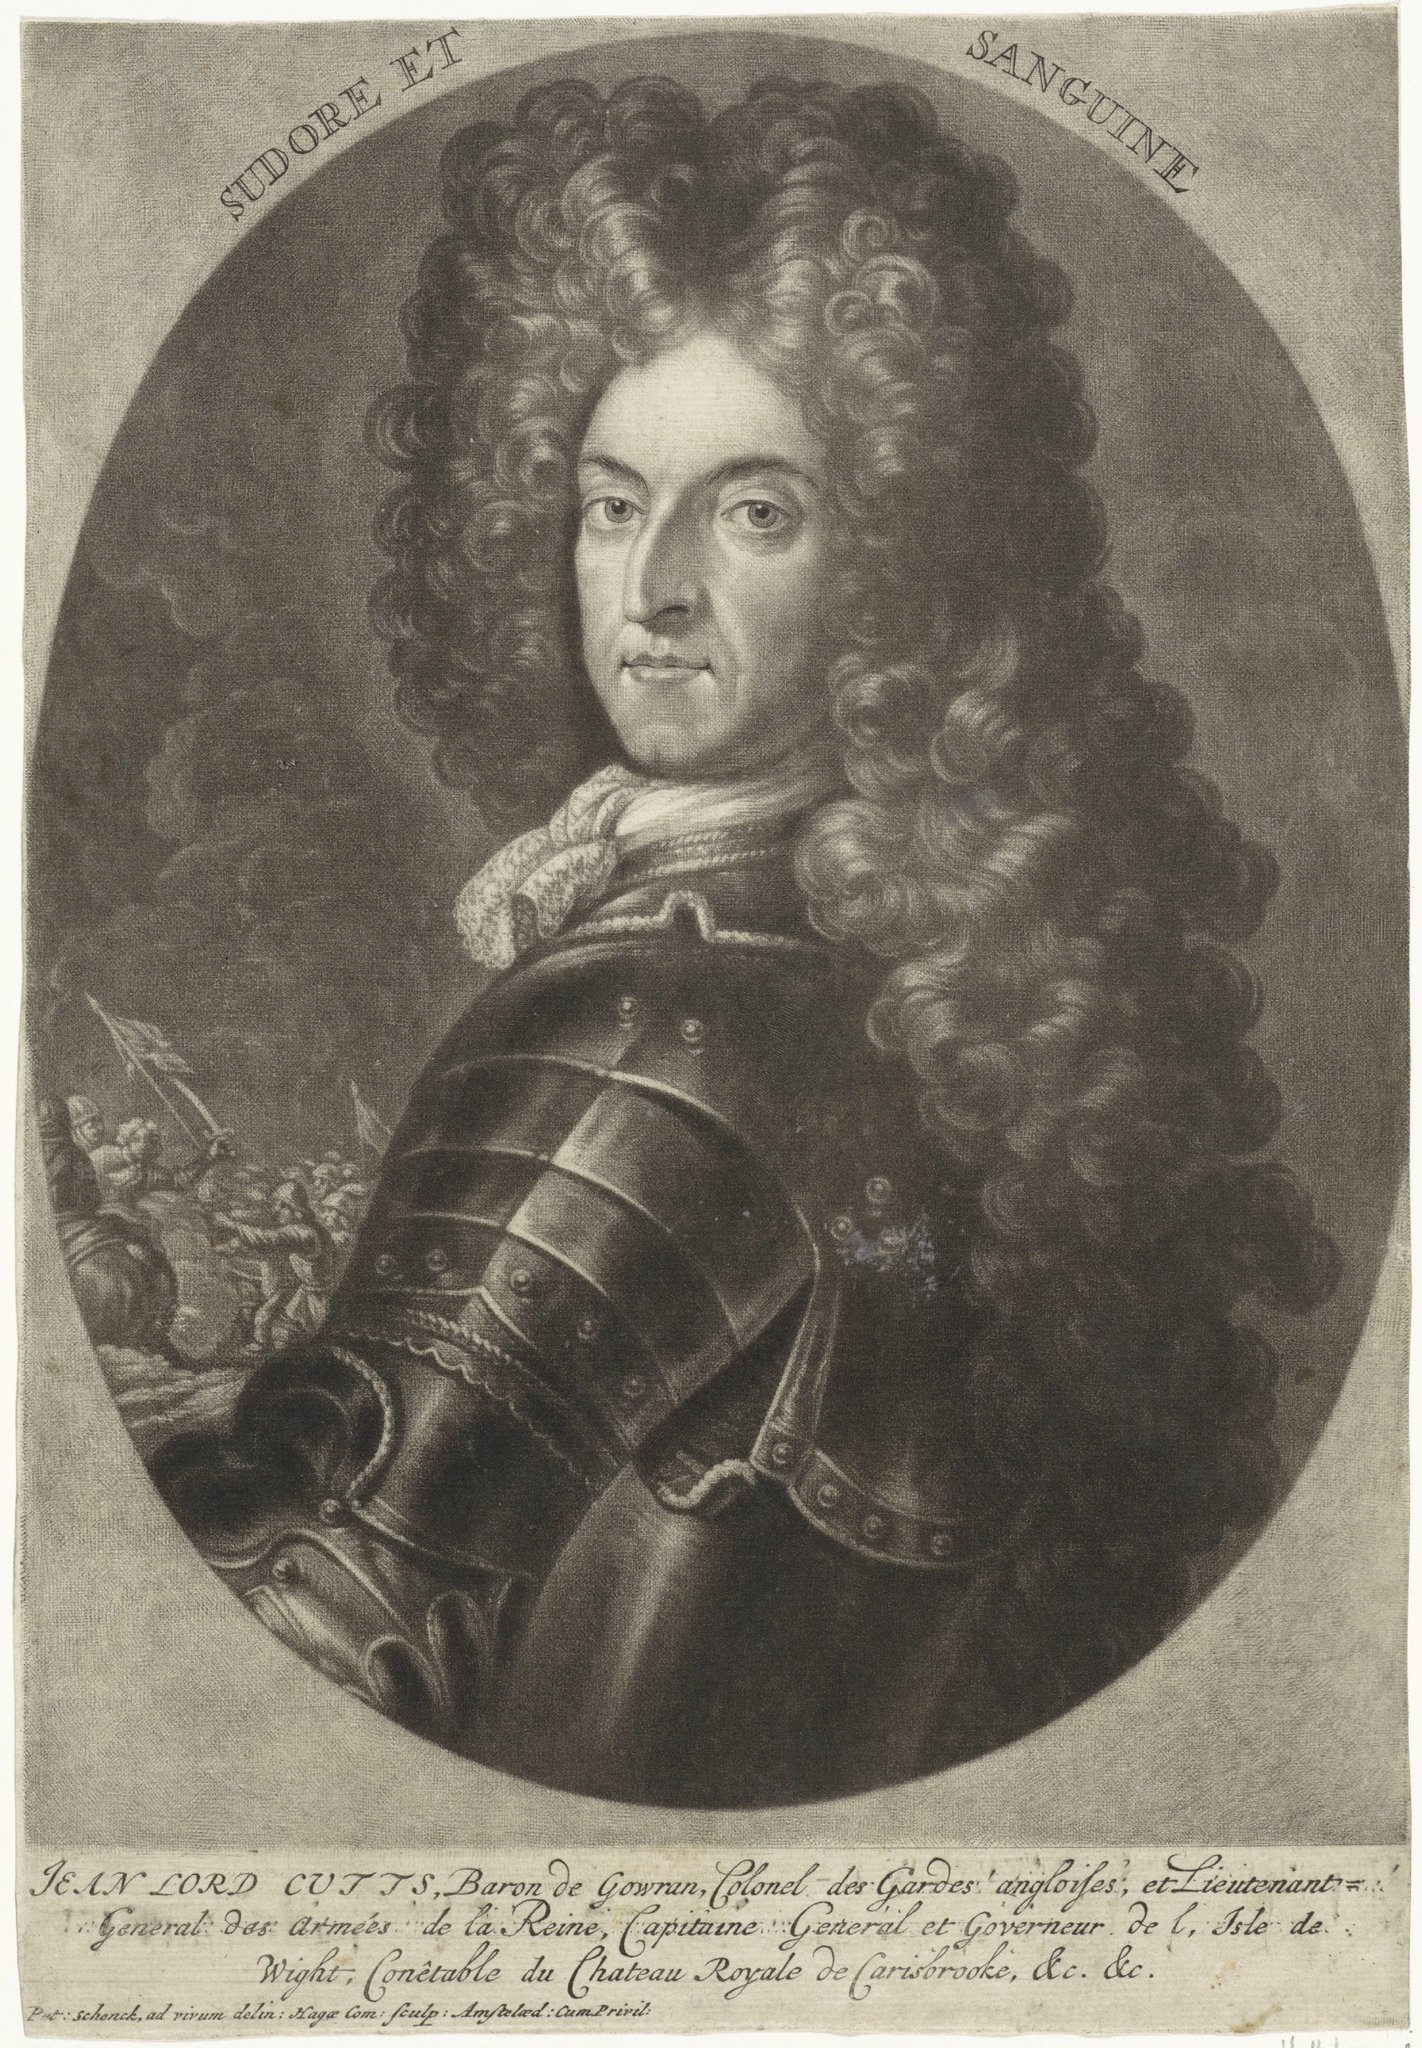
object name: print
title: Portret van Lord John Cutts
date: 1670-1713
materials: paper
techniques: engraving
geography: amsterdam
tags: battle, wig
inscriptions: collector's mark: Lugt 2228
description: De luitenant-generaal en dichter Lord John Cutts, baron van Gowran. Hij draagt een pruik en een harnas. Op de achtergrond strijdende manschappen.